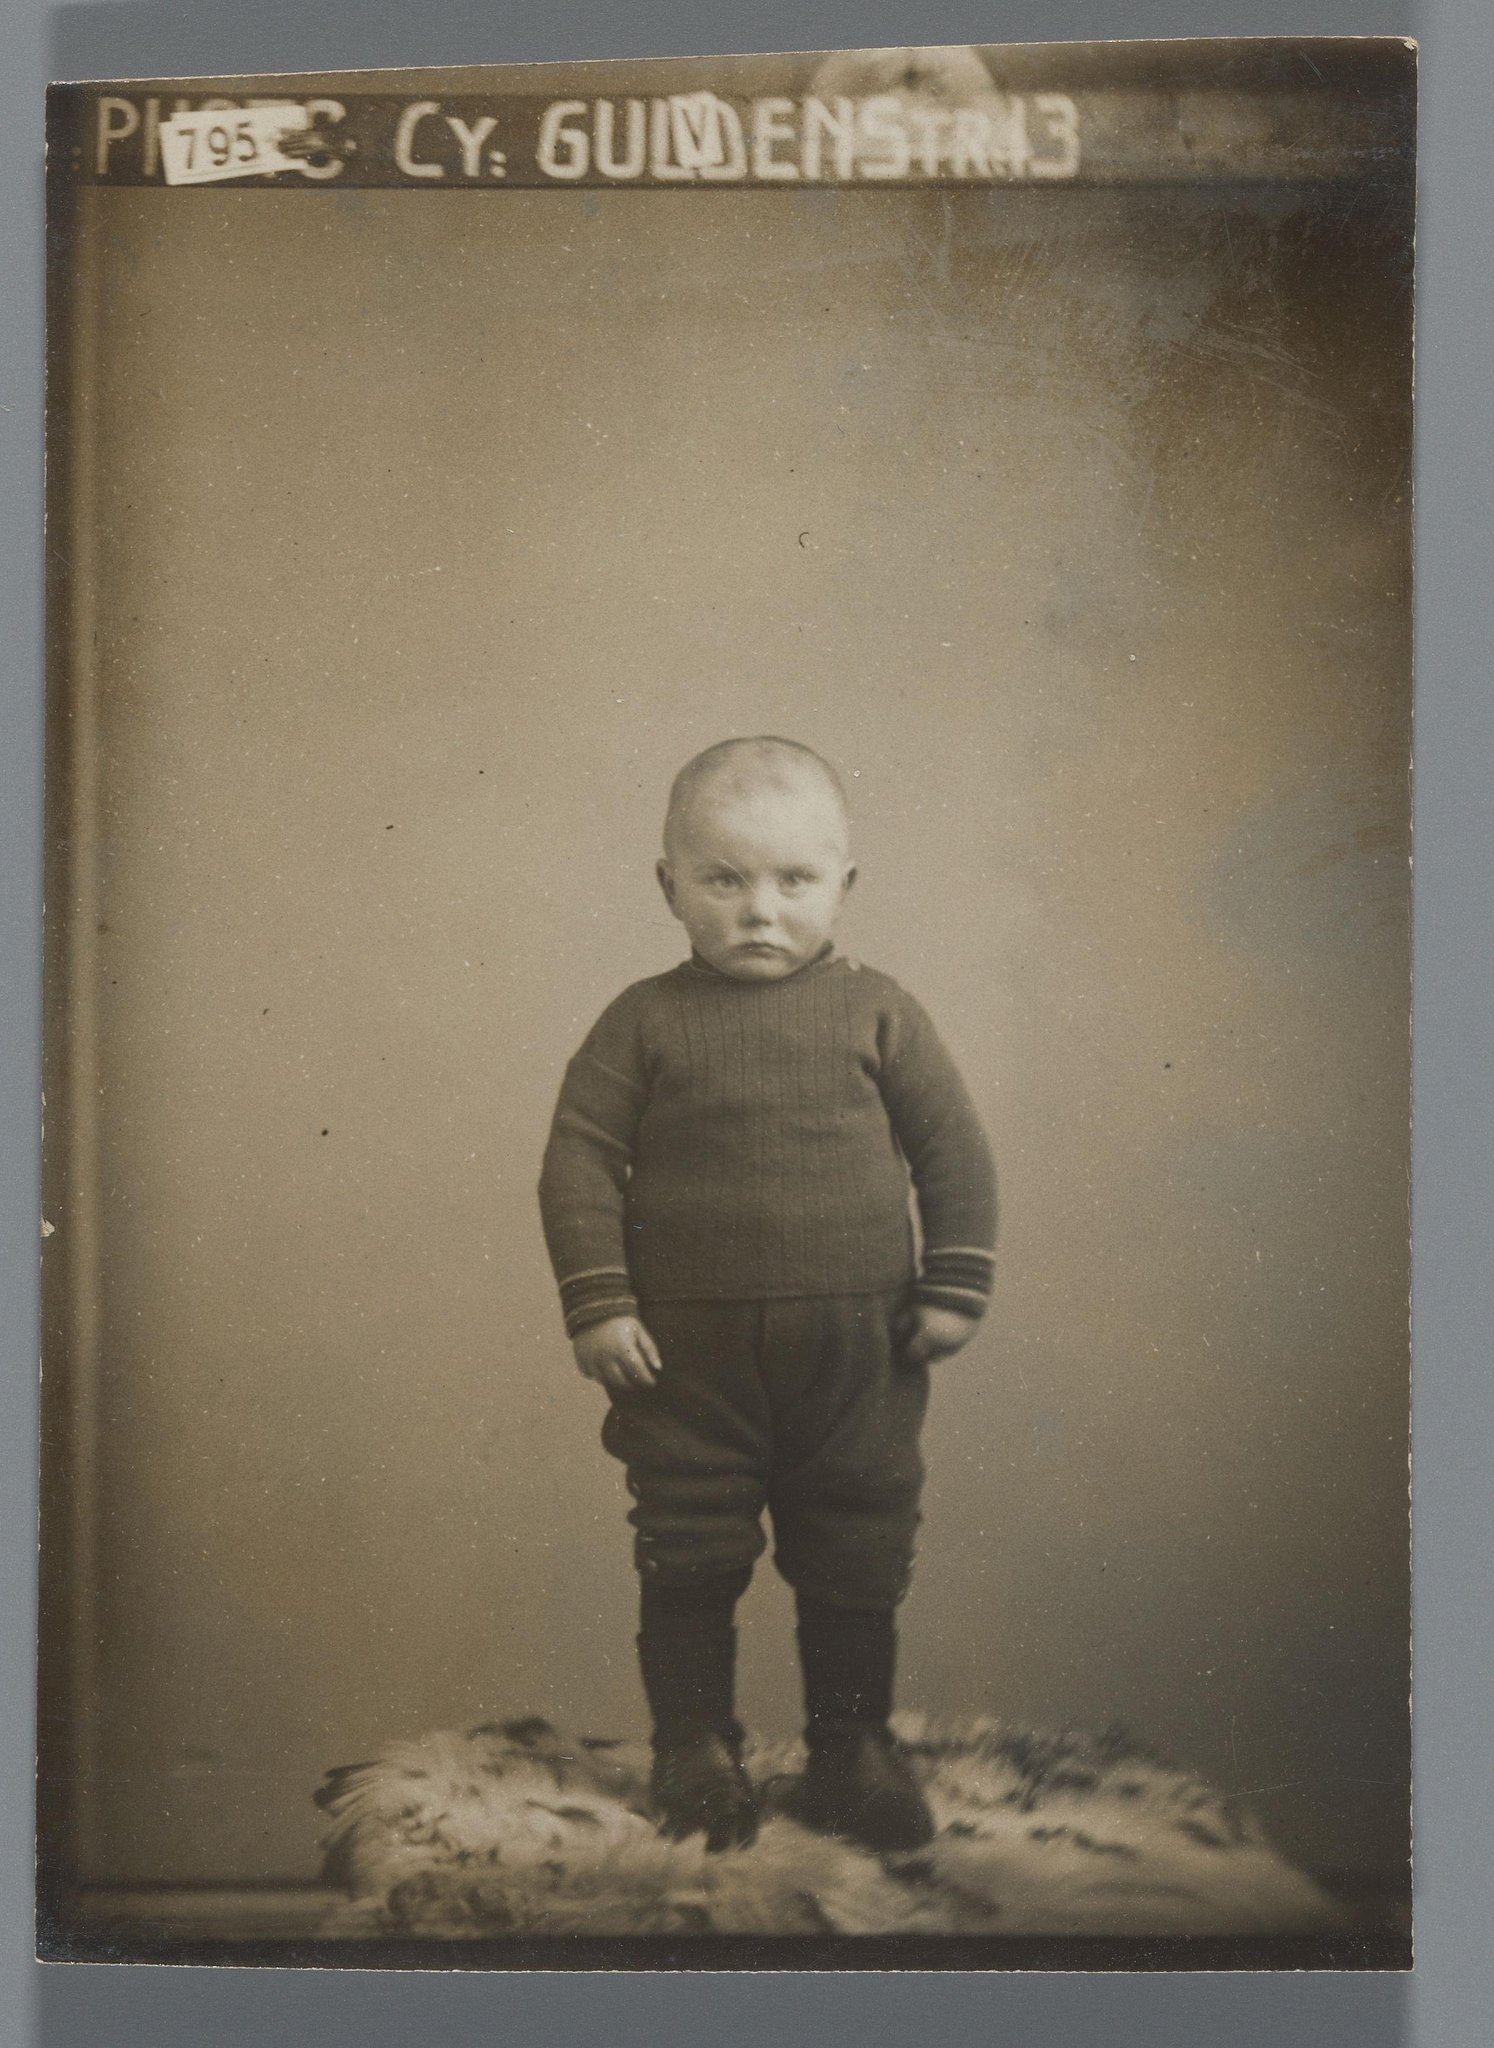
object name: snapshot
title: Portret van een jongen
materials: photographic support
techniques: gelatin silver print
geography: groningen